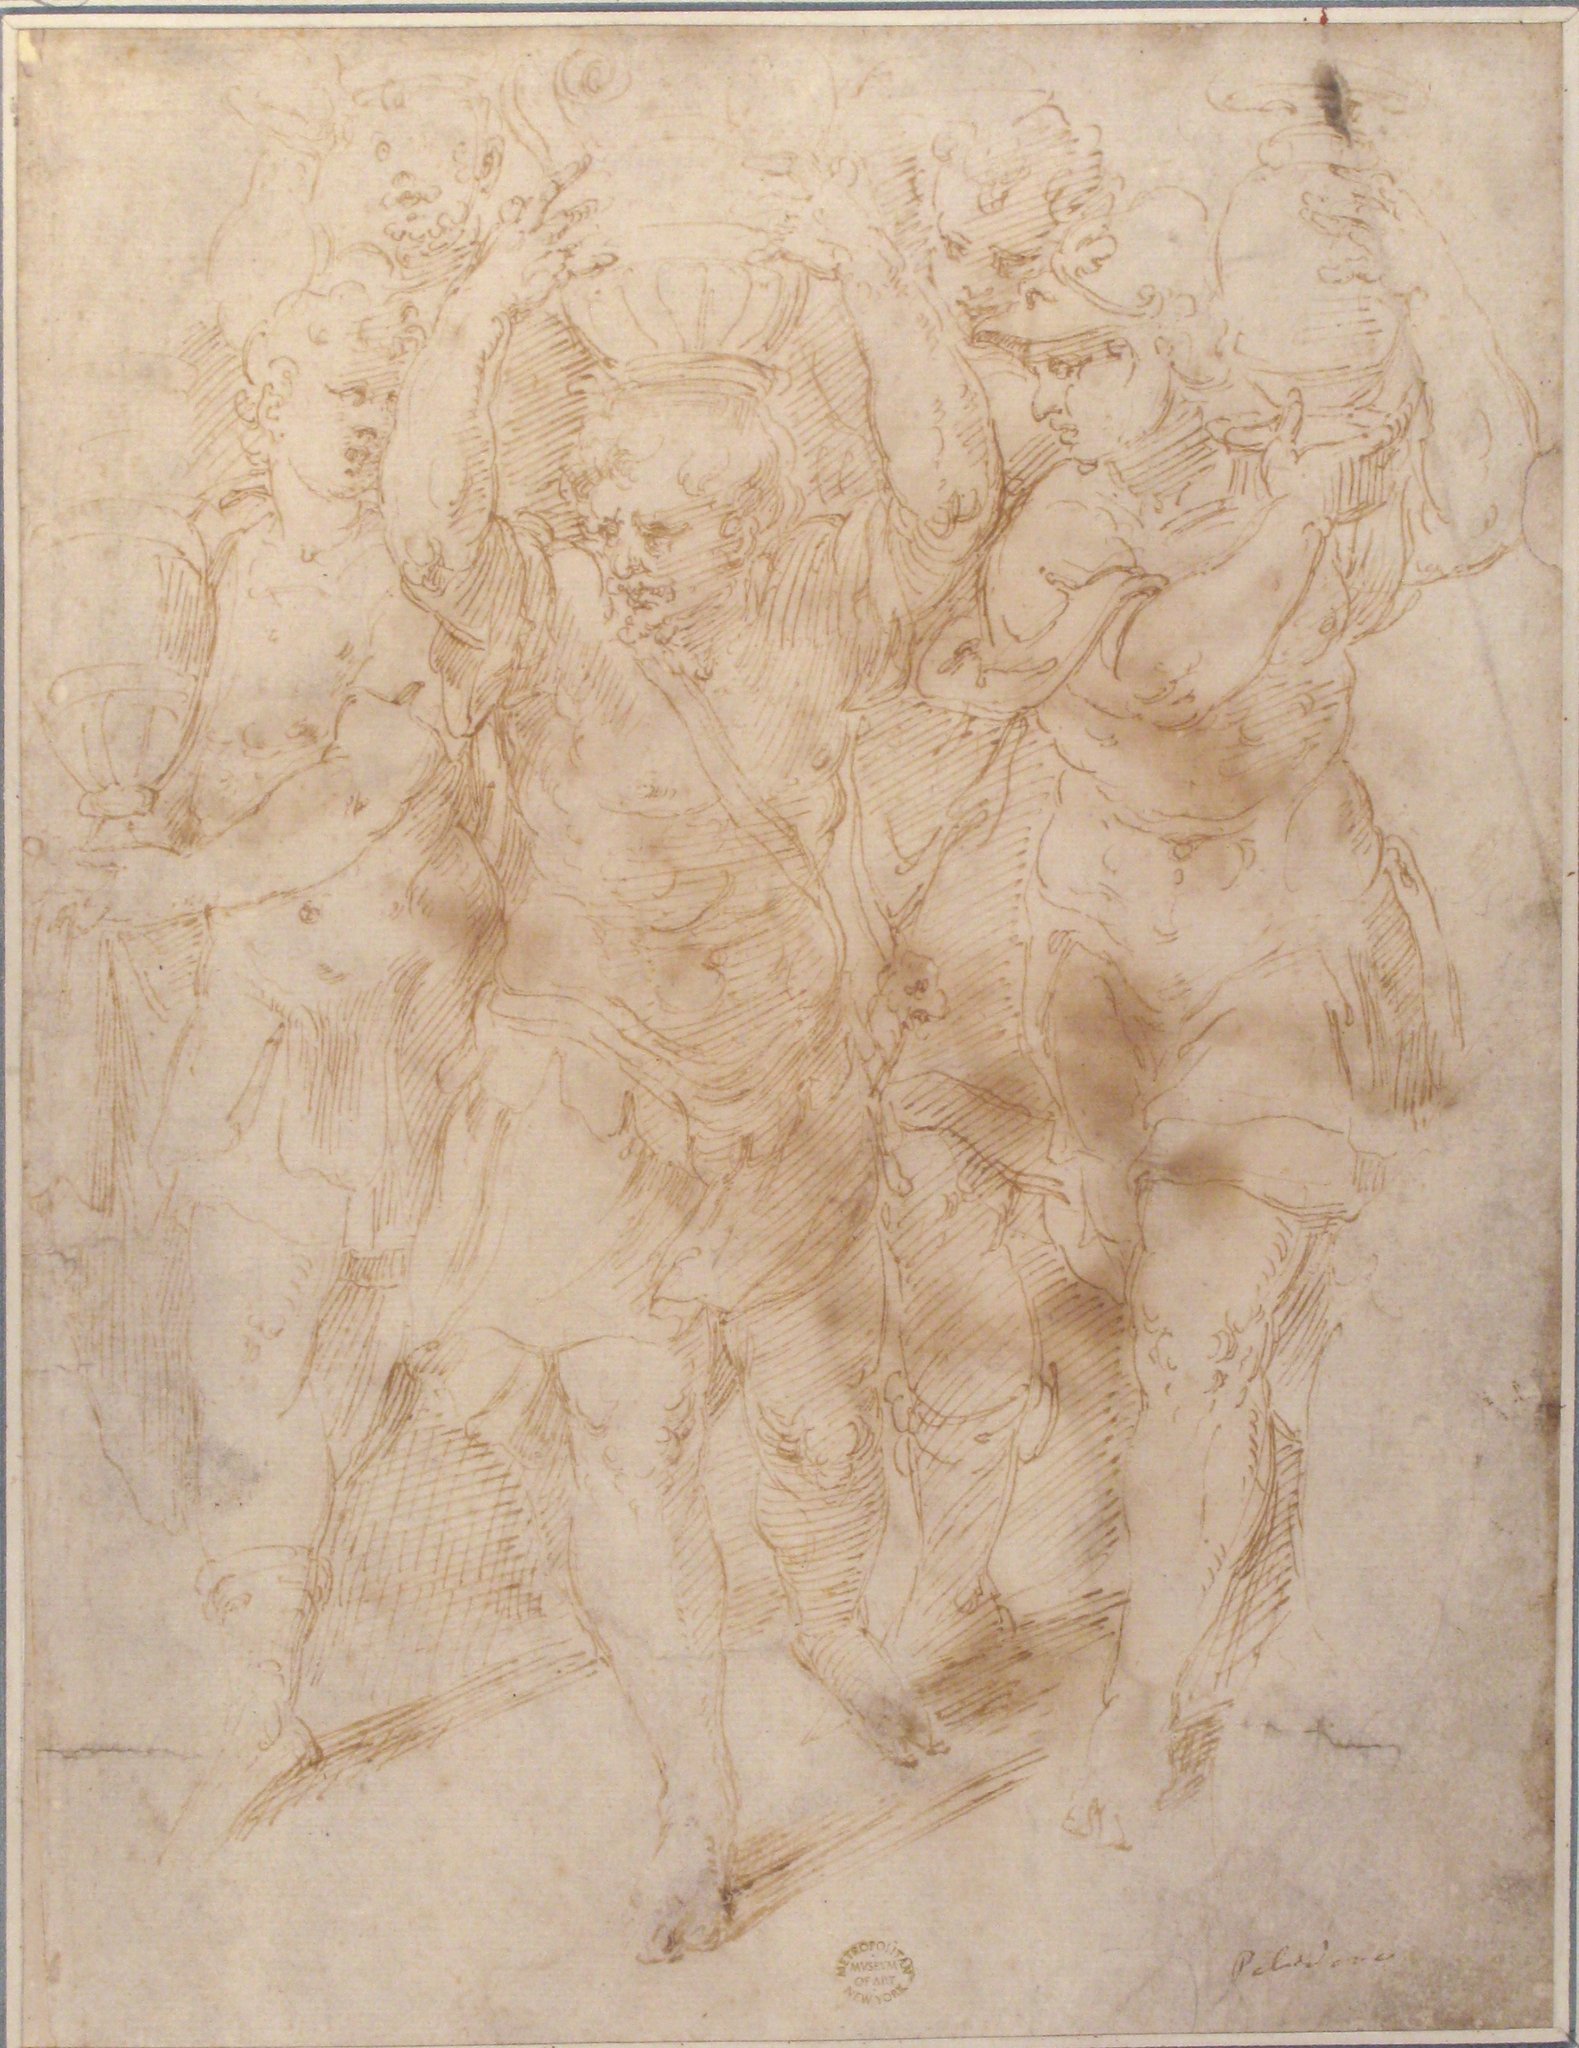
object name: drawing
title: Soldiers Carrying Urns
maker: girolamo da carpi (girolamo sellari)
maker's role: artist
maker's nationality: italian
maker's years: 1501-1556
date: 1501-1556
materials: ink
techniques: pen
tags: soldiers,men,urns